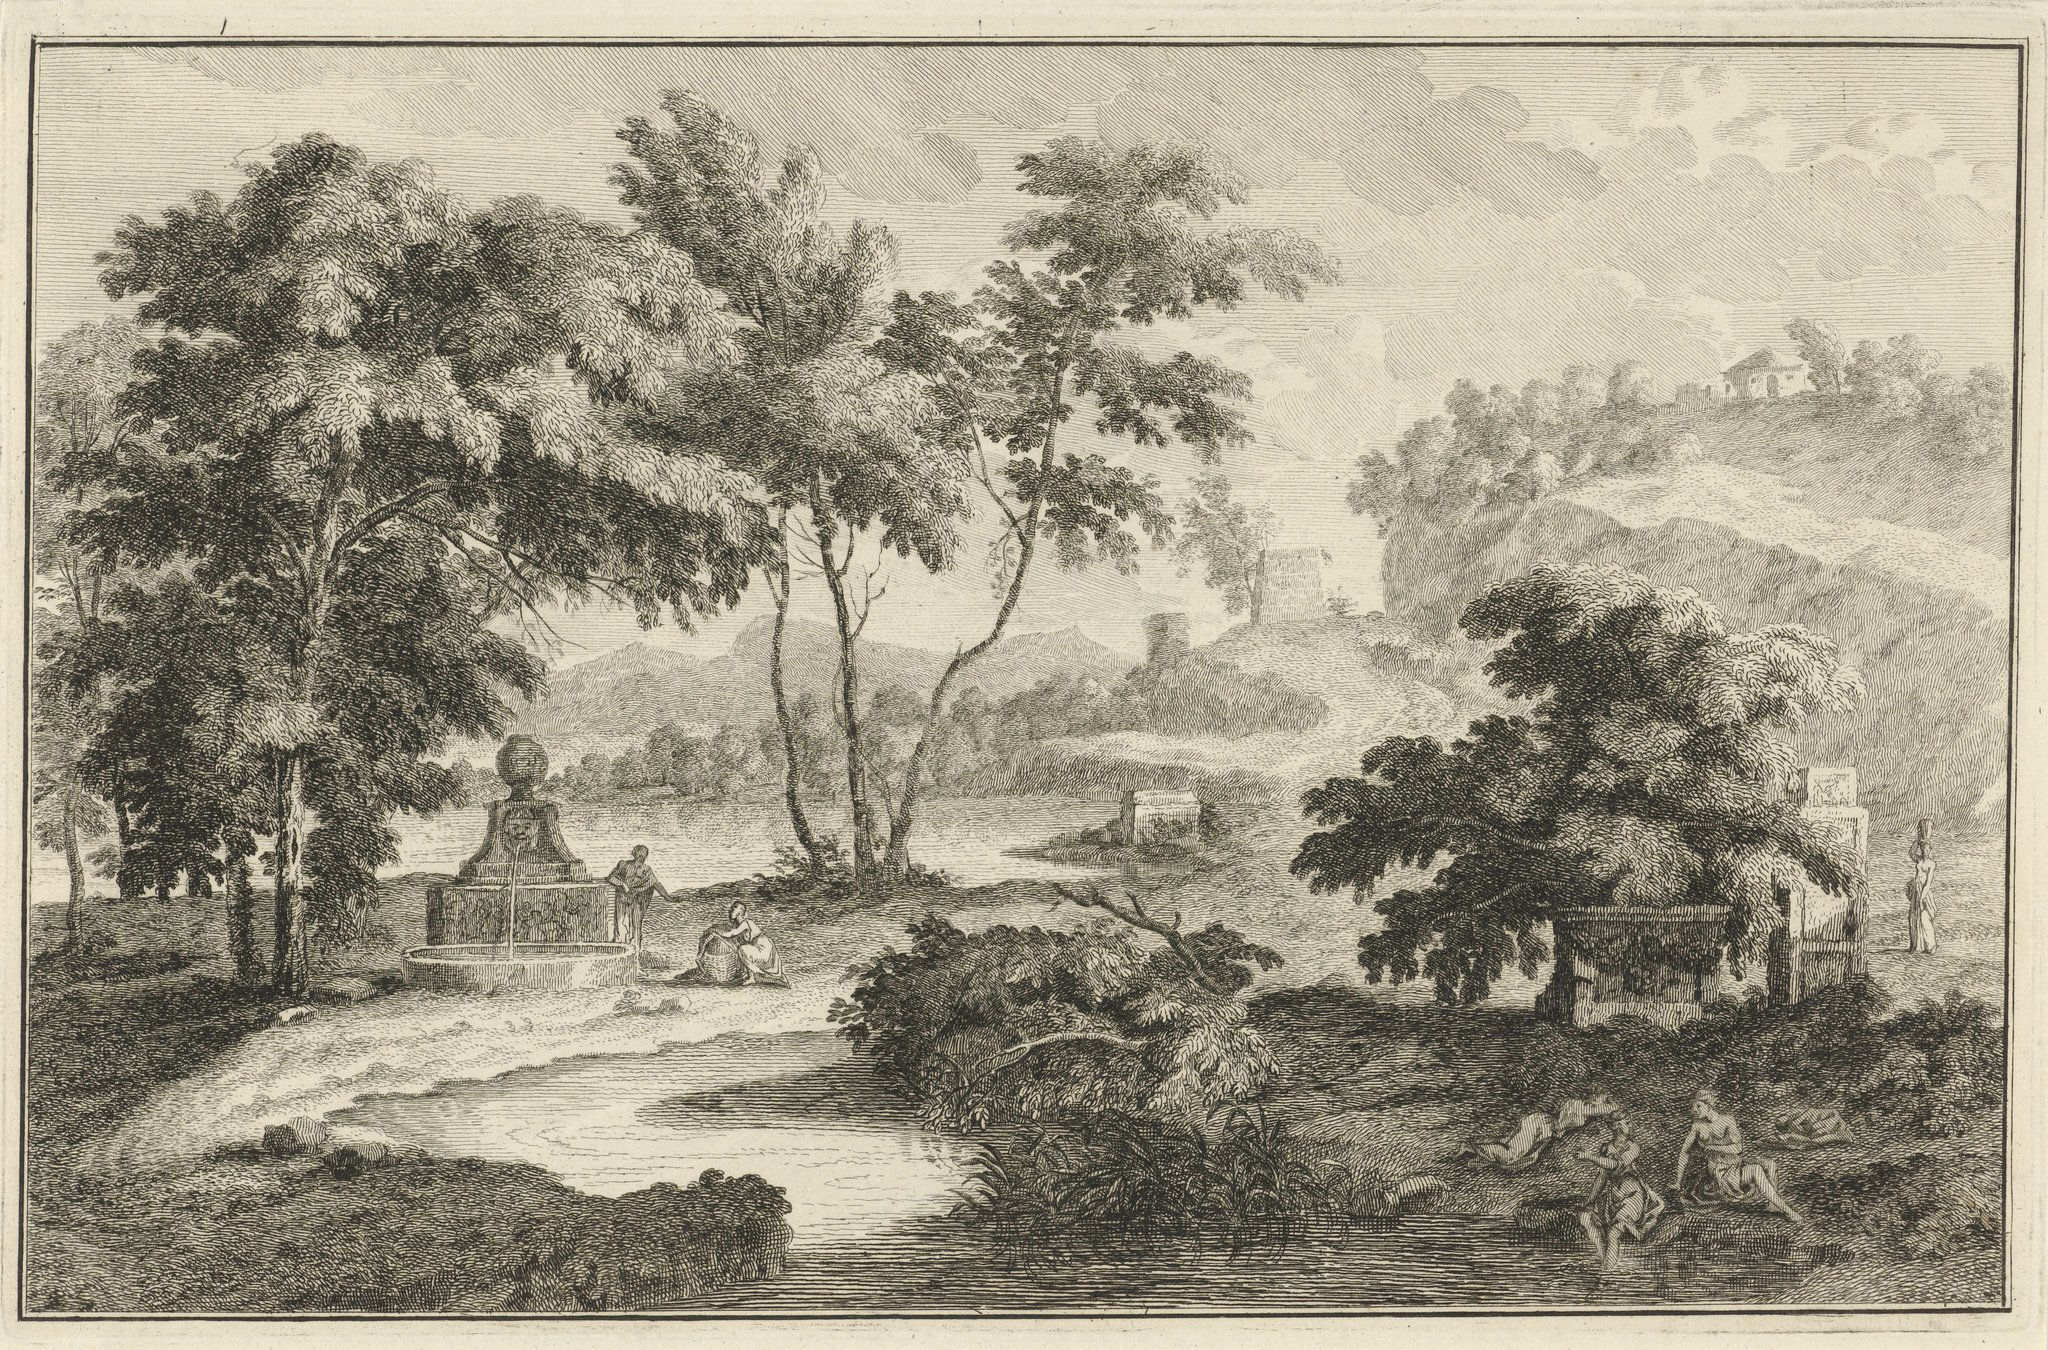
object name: print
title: Arcadisch rivierlandschap met bron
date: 1710-1747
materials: paper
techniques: etching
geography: amsterdam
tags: washing and bathing, landscapes with waters, waterscapes, seascapes (in the temperate zone), utilitarian, public pump or water fountain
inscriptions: collector's mark: Lugt 240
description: Arcadisch rivierlandschap met links twee figuren bij een bron, rechts twee badende vrouwen. De prent maakt deel uit van een 40-delige serie prenten met voorstellingen van Italiaanse en Duitse landschappen.